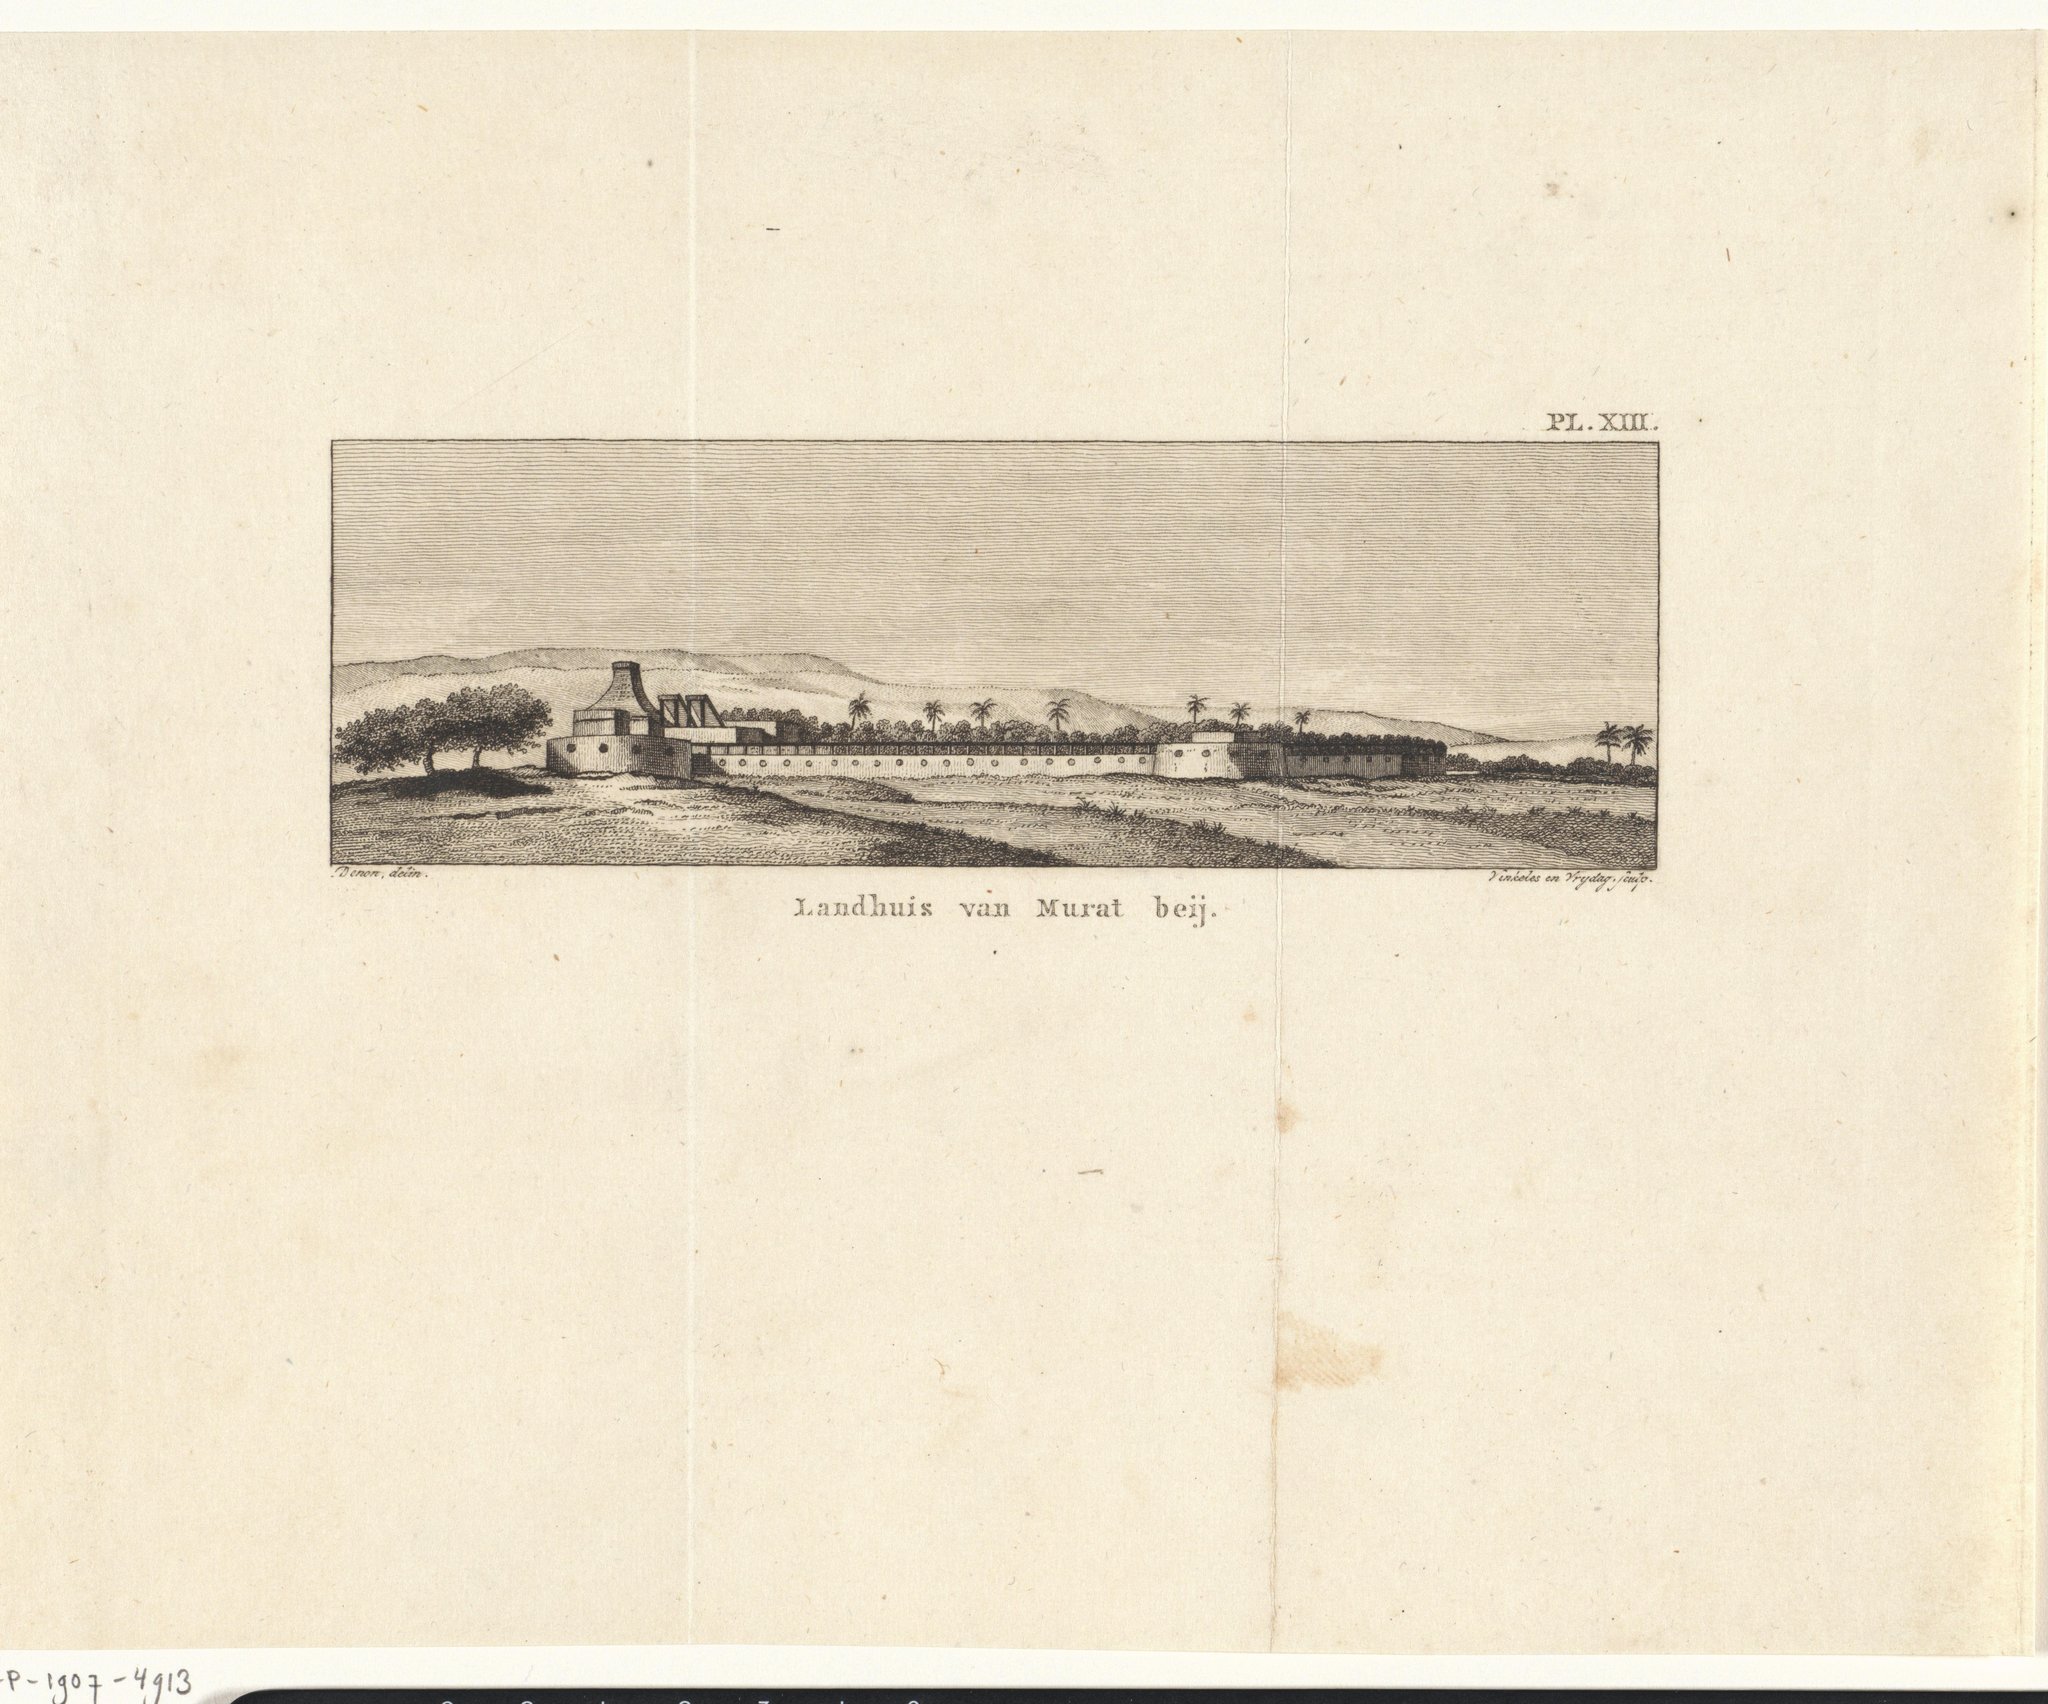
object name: print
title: Landhuis van Murat beij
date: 1803-1805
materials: paper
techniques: etching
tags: country-house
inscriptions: collector's mark: Lugt 2228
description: Prent vermoedelijk gebruikt in: Denon, Dominique Vivant [vertaald door Herman Bosscha]. Reize in Opper- en Neder-Egipte, gedurende den veldtocht van Bonaparte. 3 dln. Amsterdam: Johannes Allart, 1803-1805.